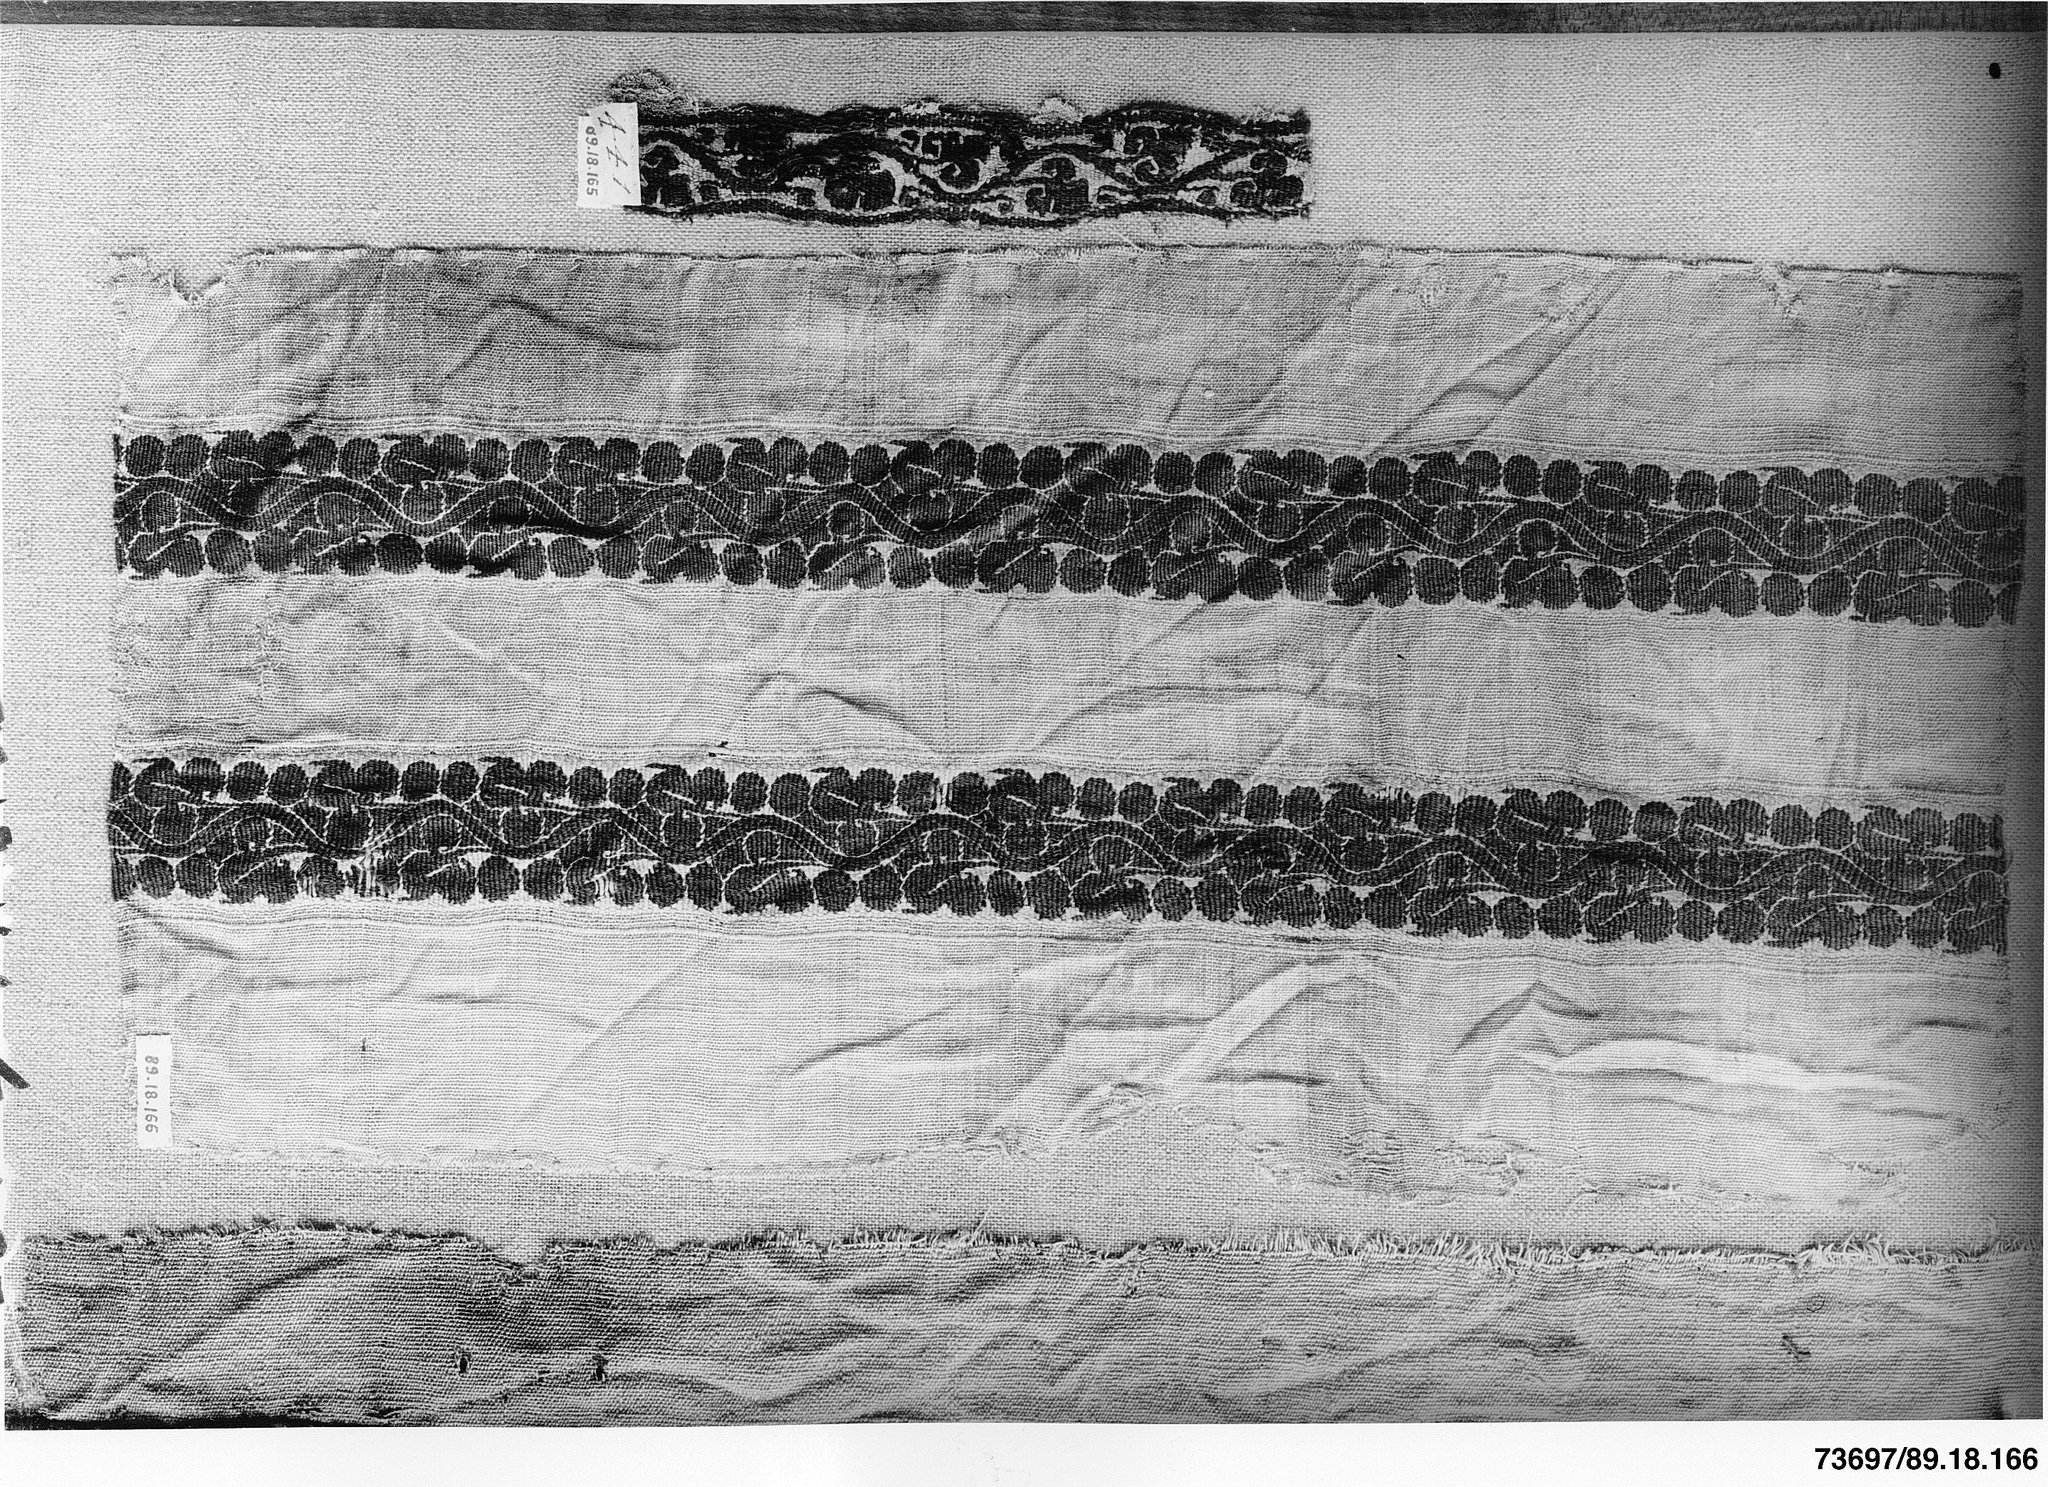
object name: textile fragment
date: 201-400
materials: linen, wool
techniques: weave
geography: egypt